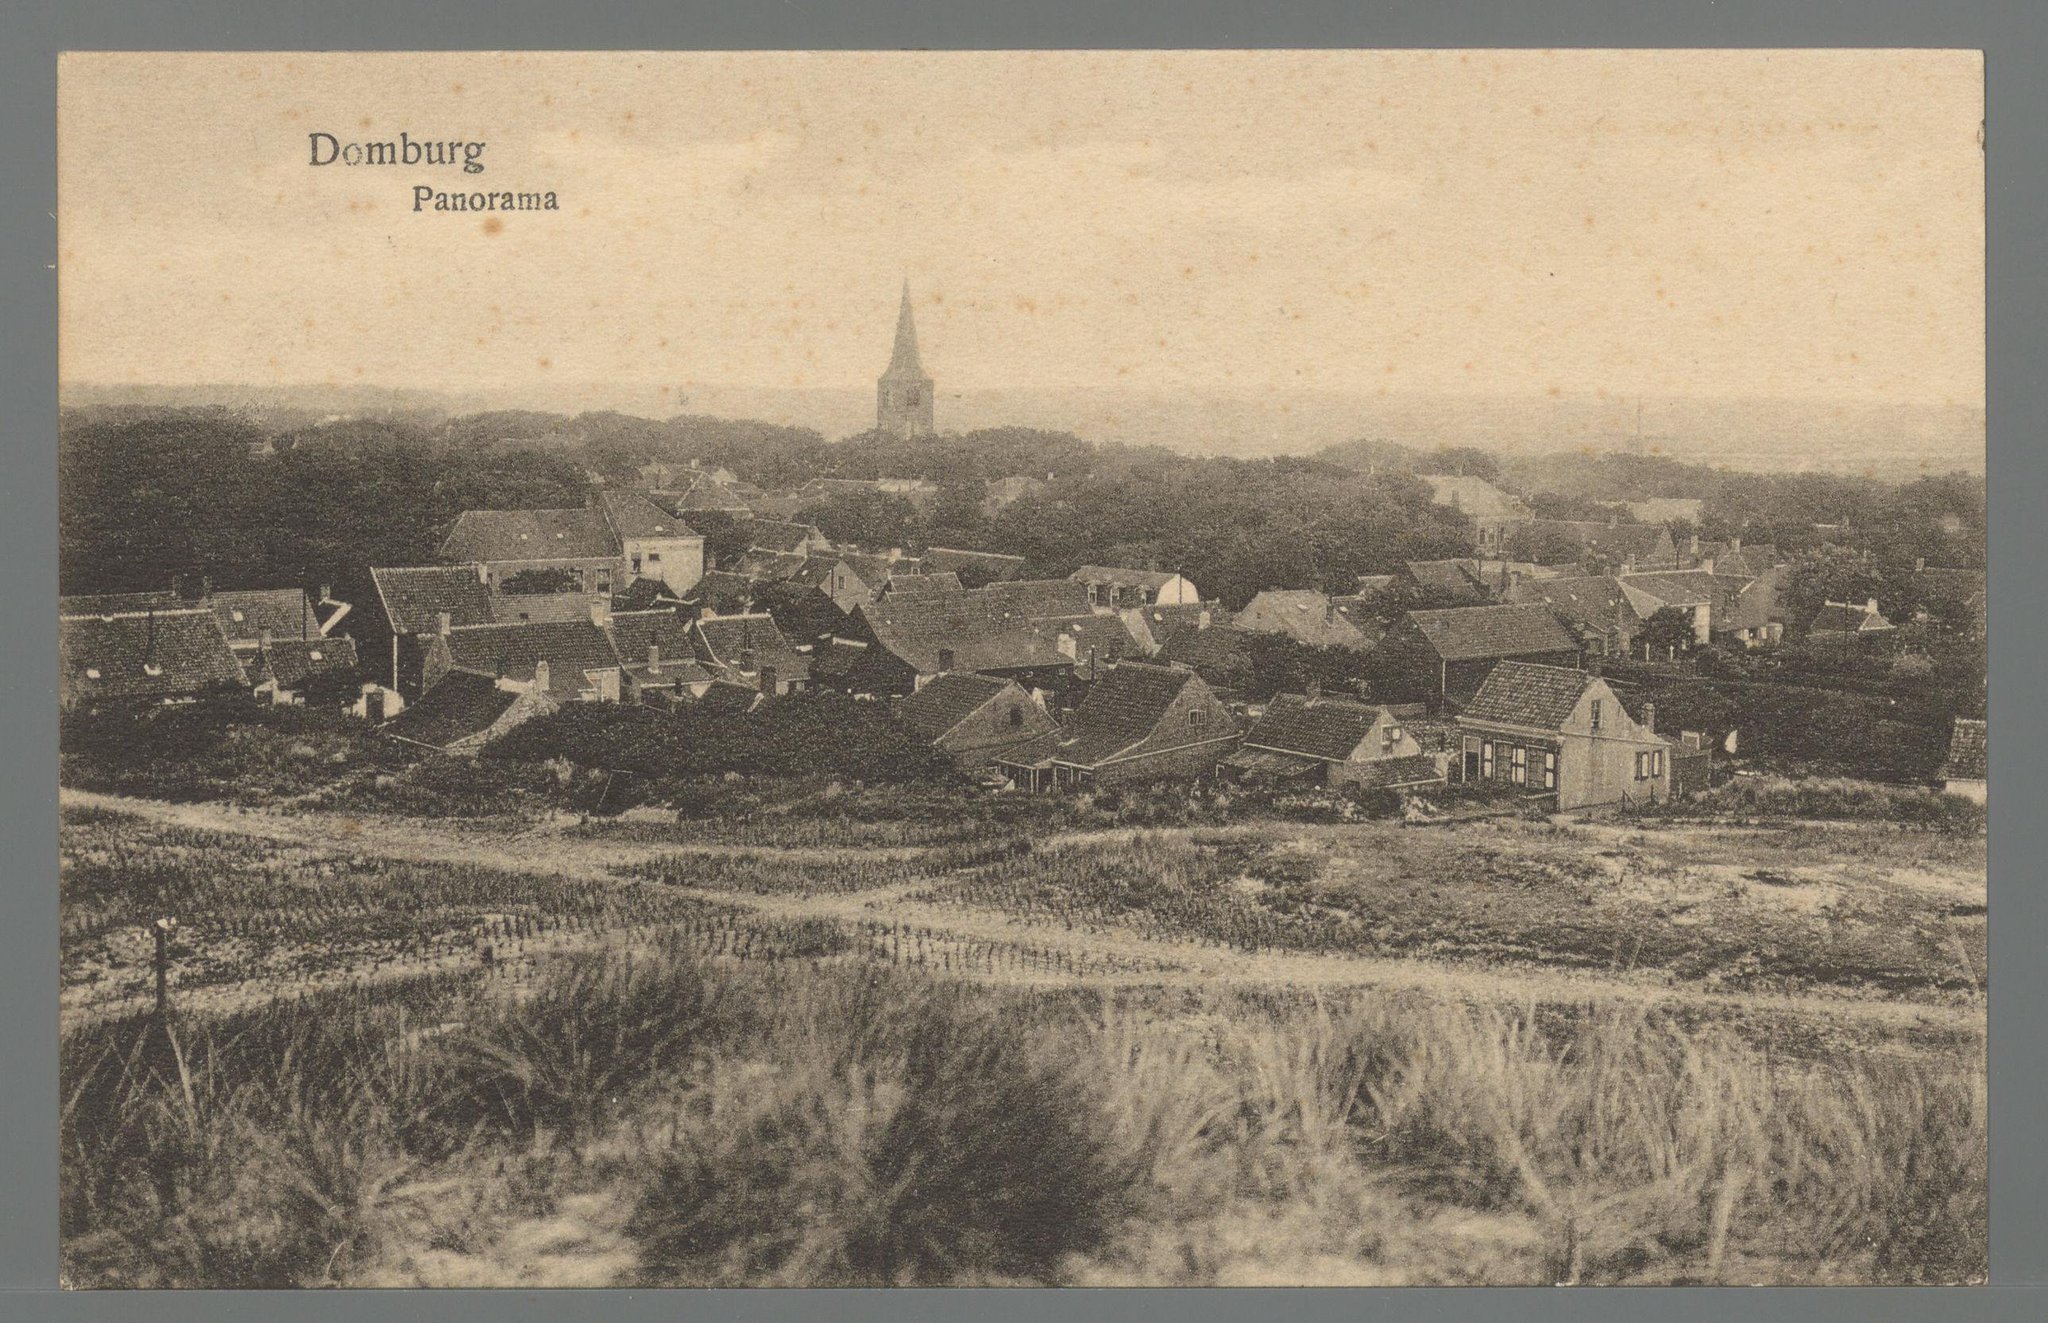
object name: photomechanical print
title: Domburg. Panorama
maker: Anonymous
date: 1918-1927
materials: cardboard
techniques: photograph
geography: domburg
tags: prospect of village, silhouette of village, dune coast